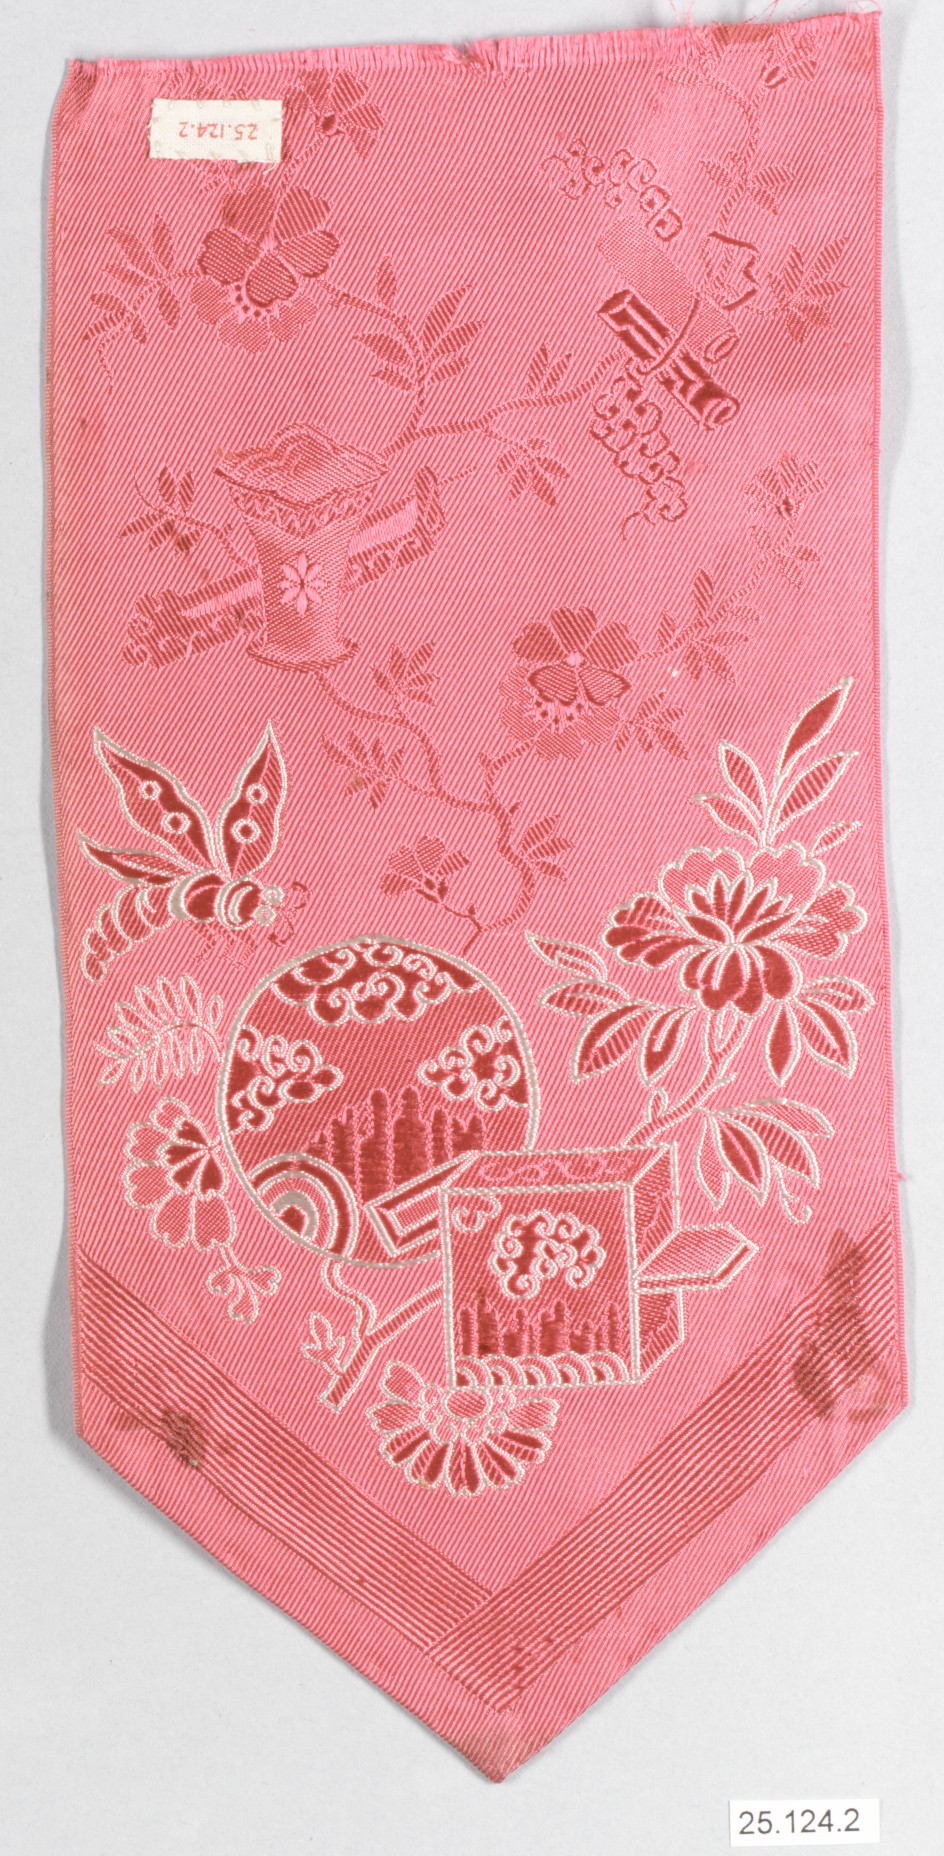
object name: necktie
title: Woman's necktie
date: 1870-1880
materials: silk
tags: insects,flowers